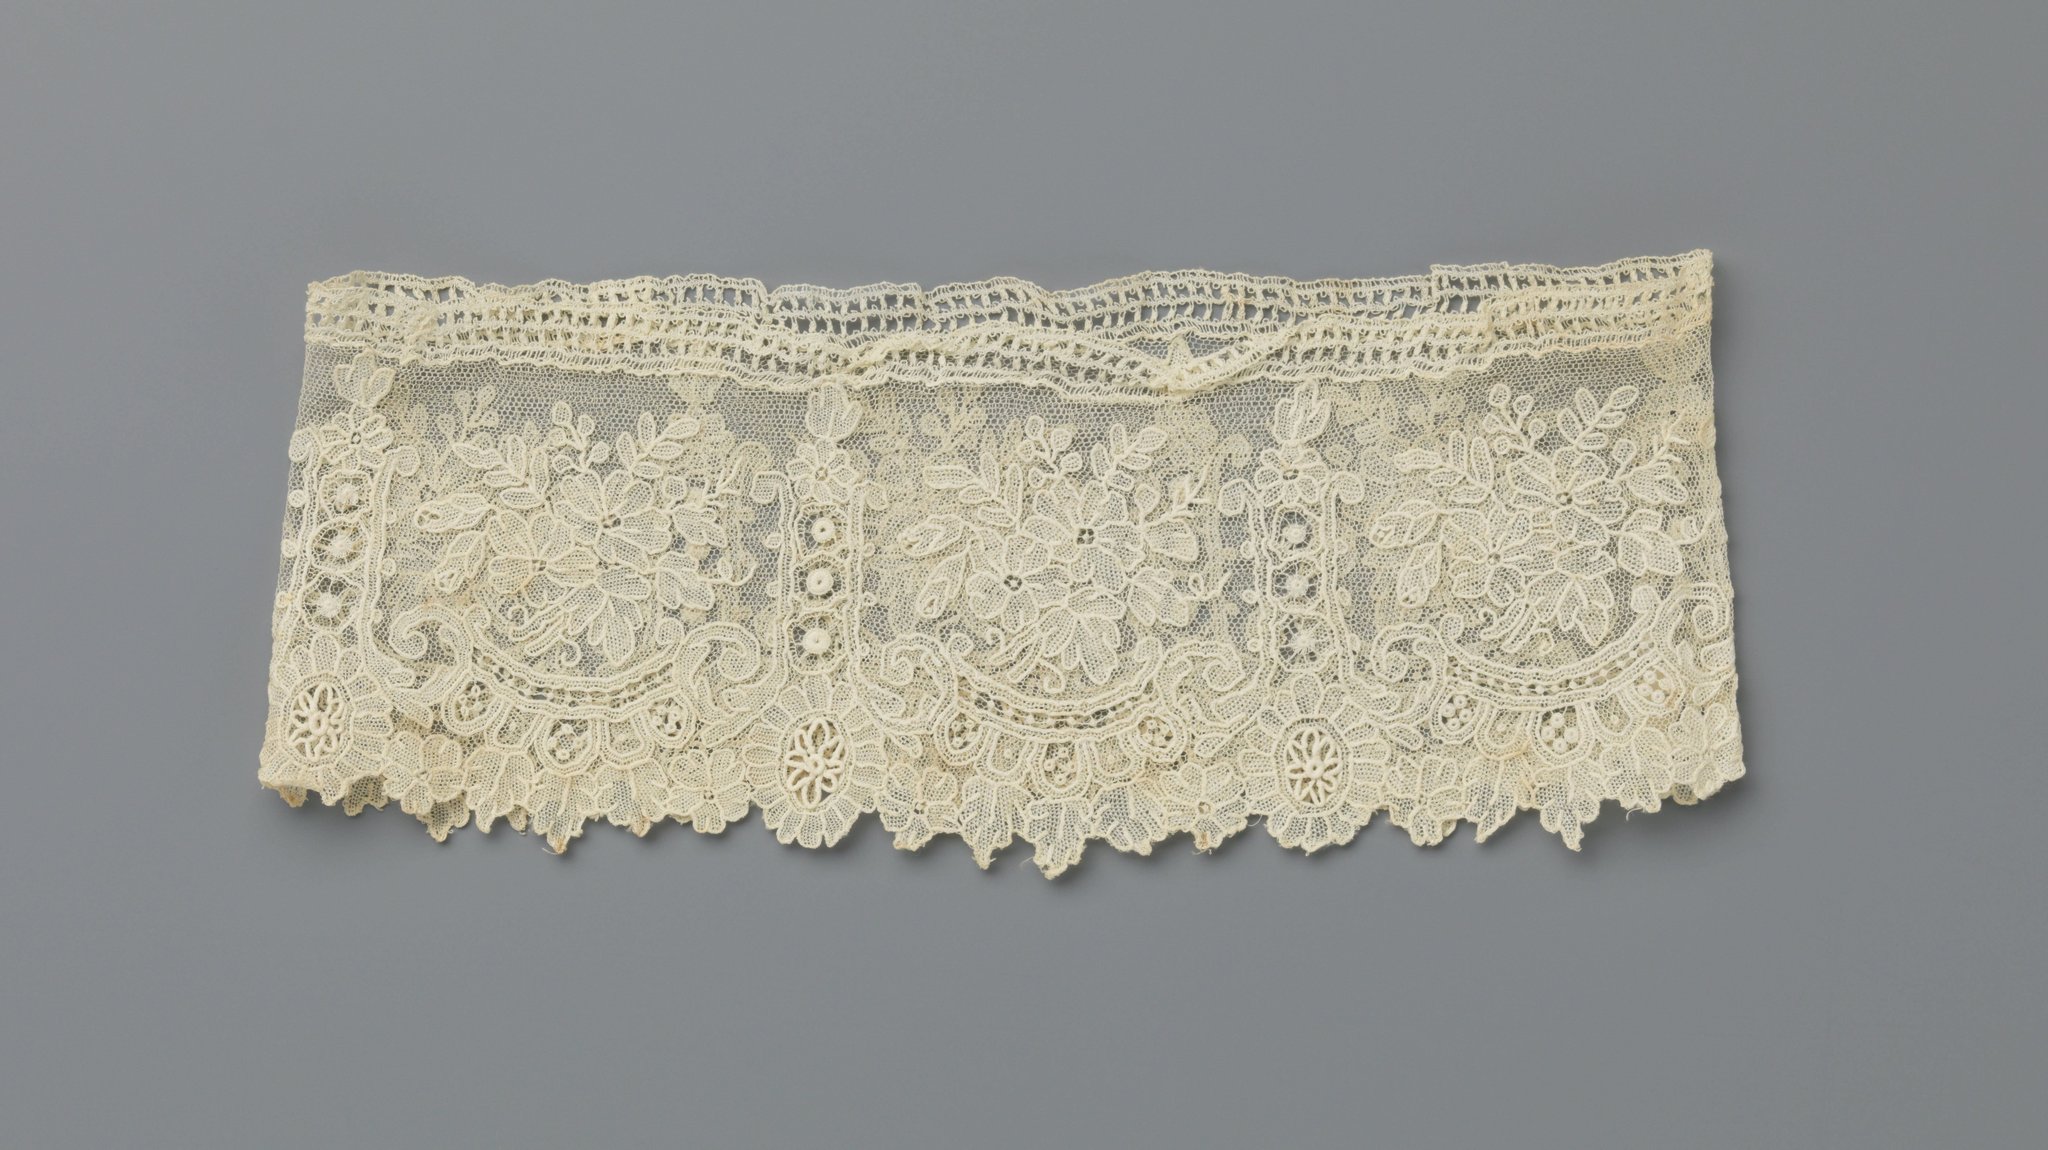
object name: cuff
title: Manchet van naaldkant met bloemtak in u-vormig cartouche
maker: Anonymous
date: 1860-1880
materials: linen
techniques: lace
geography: belgium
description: Manchet van naturelkleurige naaldkant: Brusselse gaaskant. Het zich herhalende patroon bestaat uit een u-vormig cartouche met daarin een bloemtak met twee rozetbloemen en twee kelkbloempjes. De 'poten' van de u worden gevormd door twee rechte pilaren, bekroond door een rozetbloempje en drielobbig blad. Onder elke pilaar hangt een ovaal medaillon met een rozetbloem in het centrum. Tussen de pilaren en de opeenvolgende medaillons hangt een sierlijst met vijf lobben en daaronder een slinger van drie bladeren tussen twee rozetbloempjes. De medaillons zorgen samen met deze slinger voor de schulpenrand langs de onderzijde van de strook. De motieven zijn voorzien van contourdraden, de drie cirkeltjes in de pilaren en de rozetbloem in elk medaillon zijn voorzien van dikkere reliëfcontouren. De motieven zijn met elkaar verbonden door een fijne maasgrond, een gaaskantgrond. De bovenzijde van het manchet is afgewerkt met een apart geklost bandje. De uiteinden van het manchet zijn schijnbaar onzichtbaar aan elkaar bevestigd.